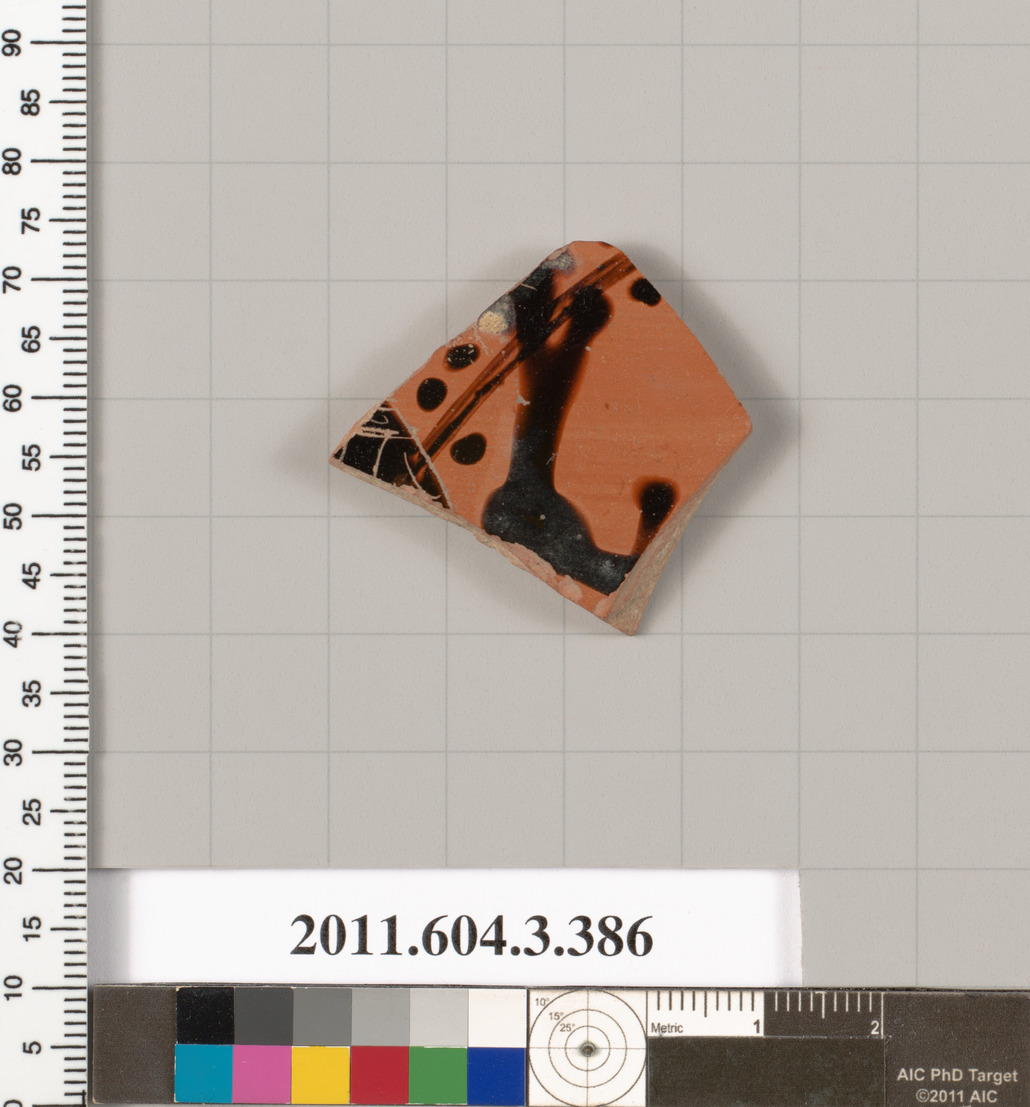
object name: neck amphora fragment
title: Terracotta fragment of a neck-amphora (jar)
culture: greek, attic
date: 525-501 BCE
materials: terracotta